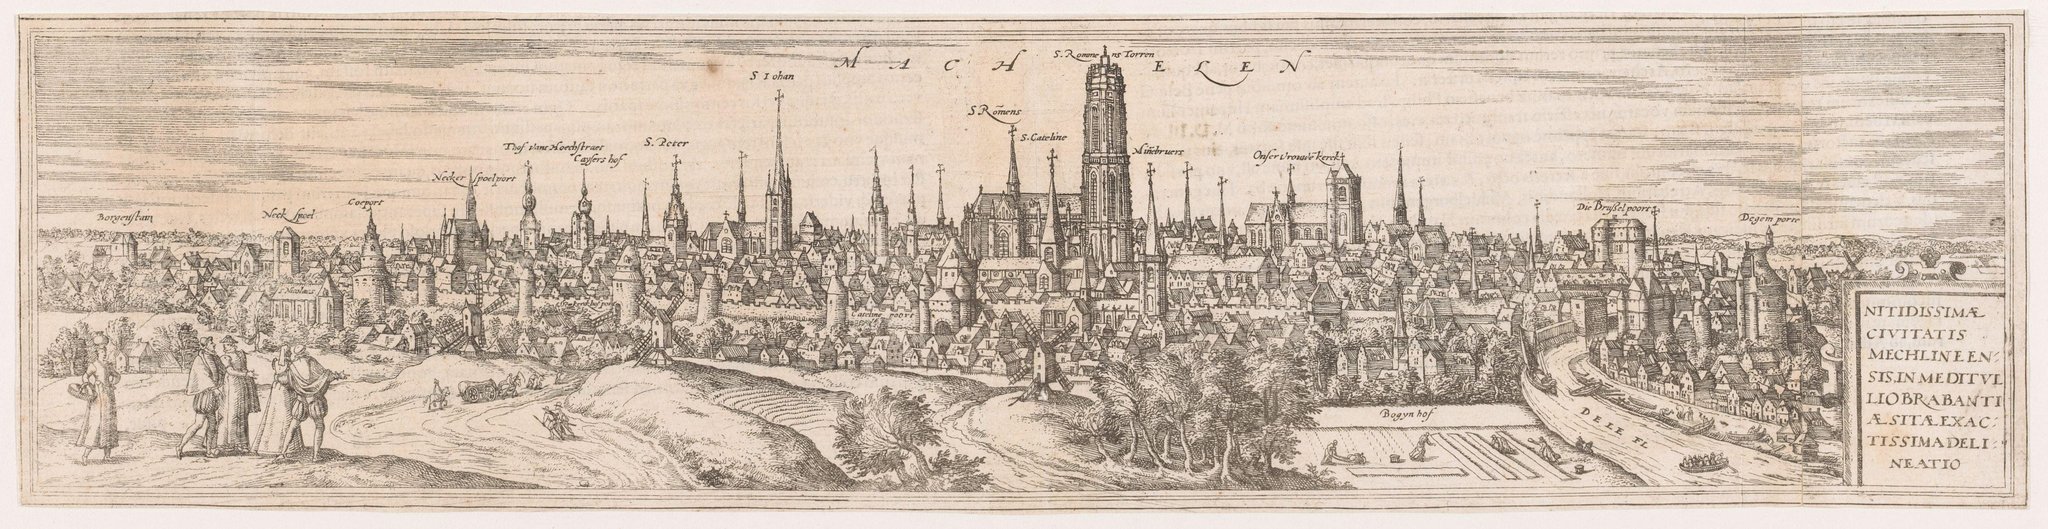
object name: print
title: Machelen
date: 1682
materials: paper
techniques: etching, letterpress printing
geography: amsterdam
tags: city-view in general; 'veduta', mechelen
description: Prent uit: Tooneel der vermaarste koop-steden (...). 2 dln. Amsterdam: Ervan Johannes Janssonius van Waesberge, 1682, dl. 1, kaart 45.